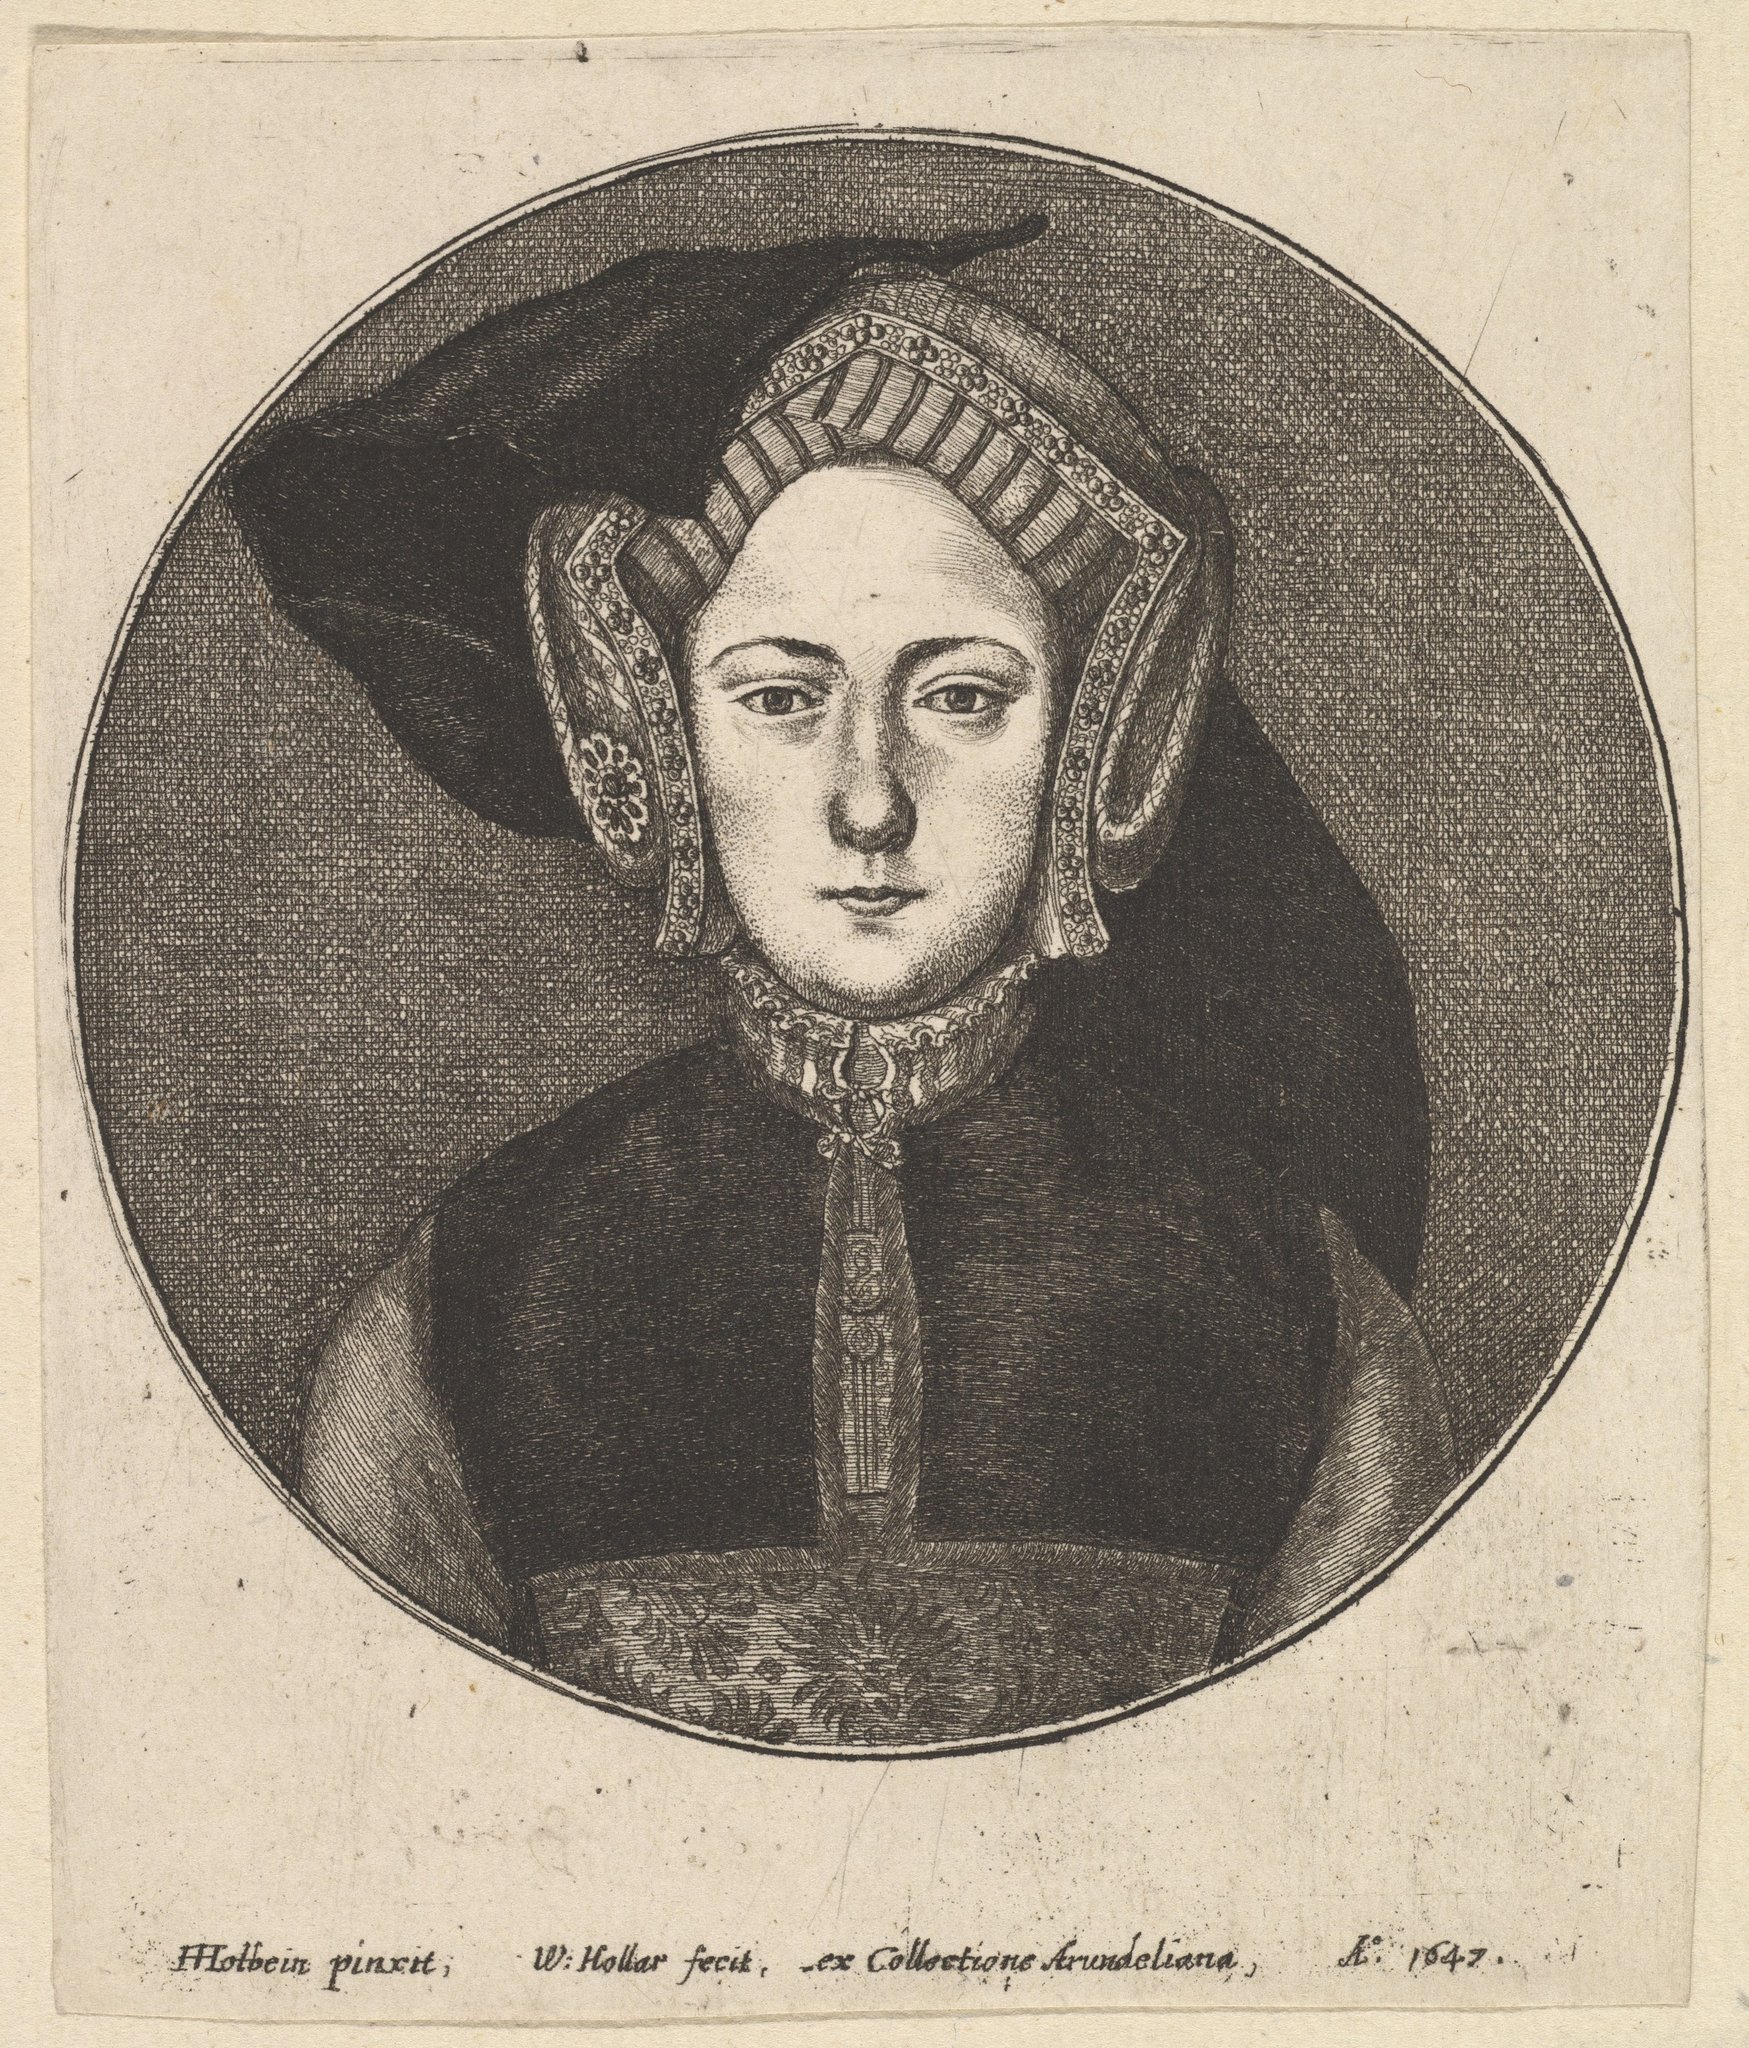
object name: print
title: Portrait of a Young Woman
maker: wenceslaus hollar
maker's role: artist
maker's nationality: bohemian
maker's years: 1607-1677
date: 1647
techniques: drypoint, etching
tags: portraits,women